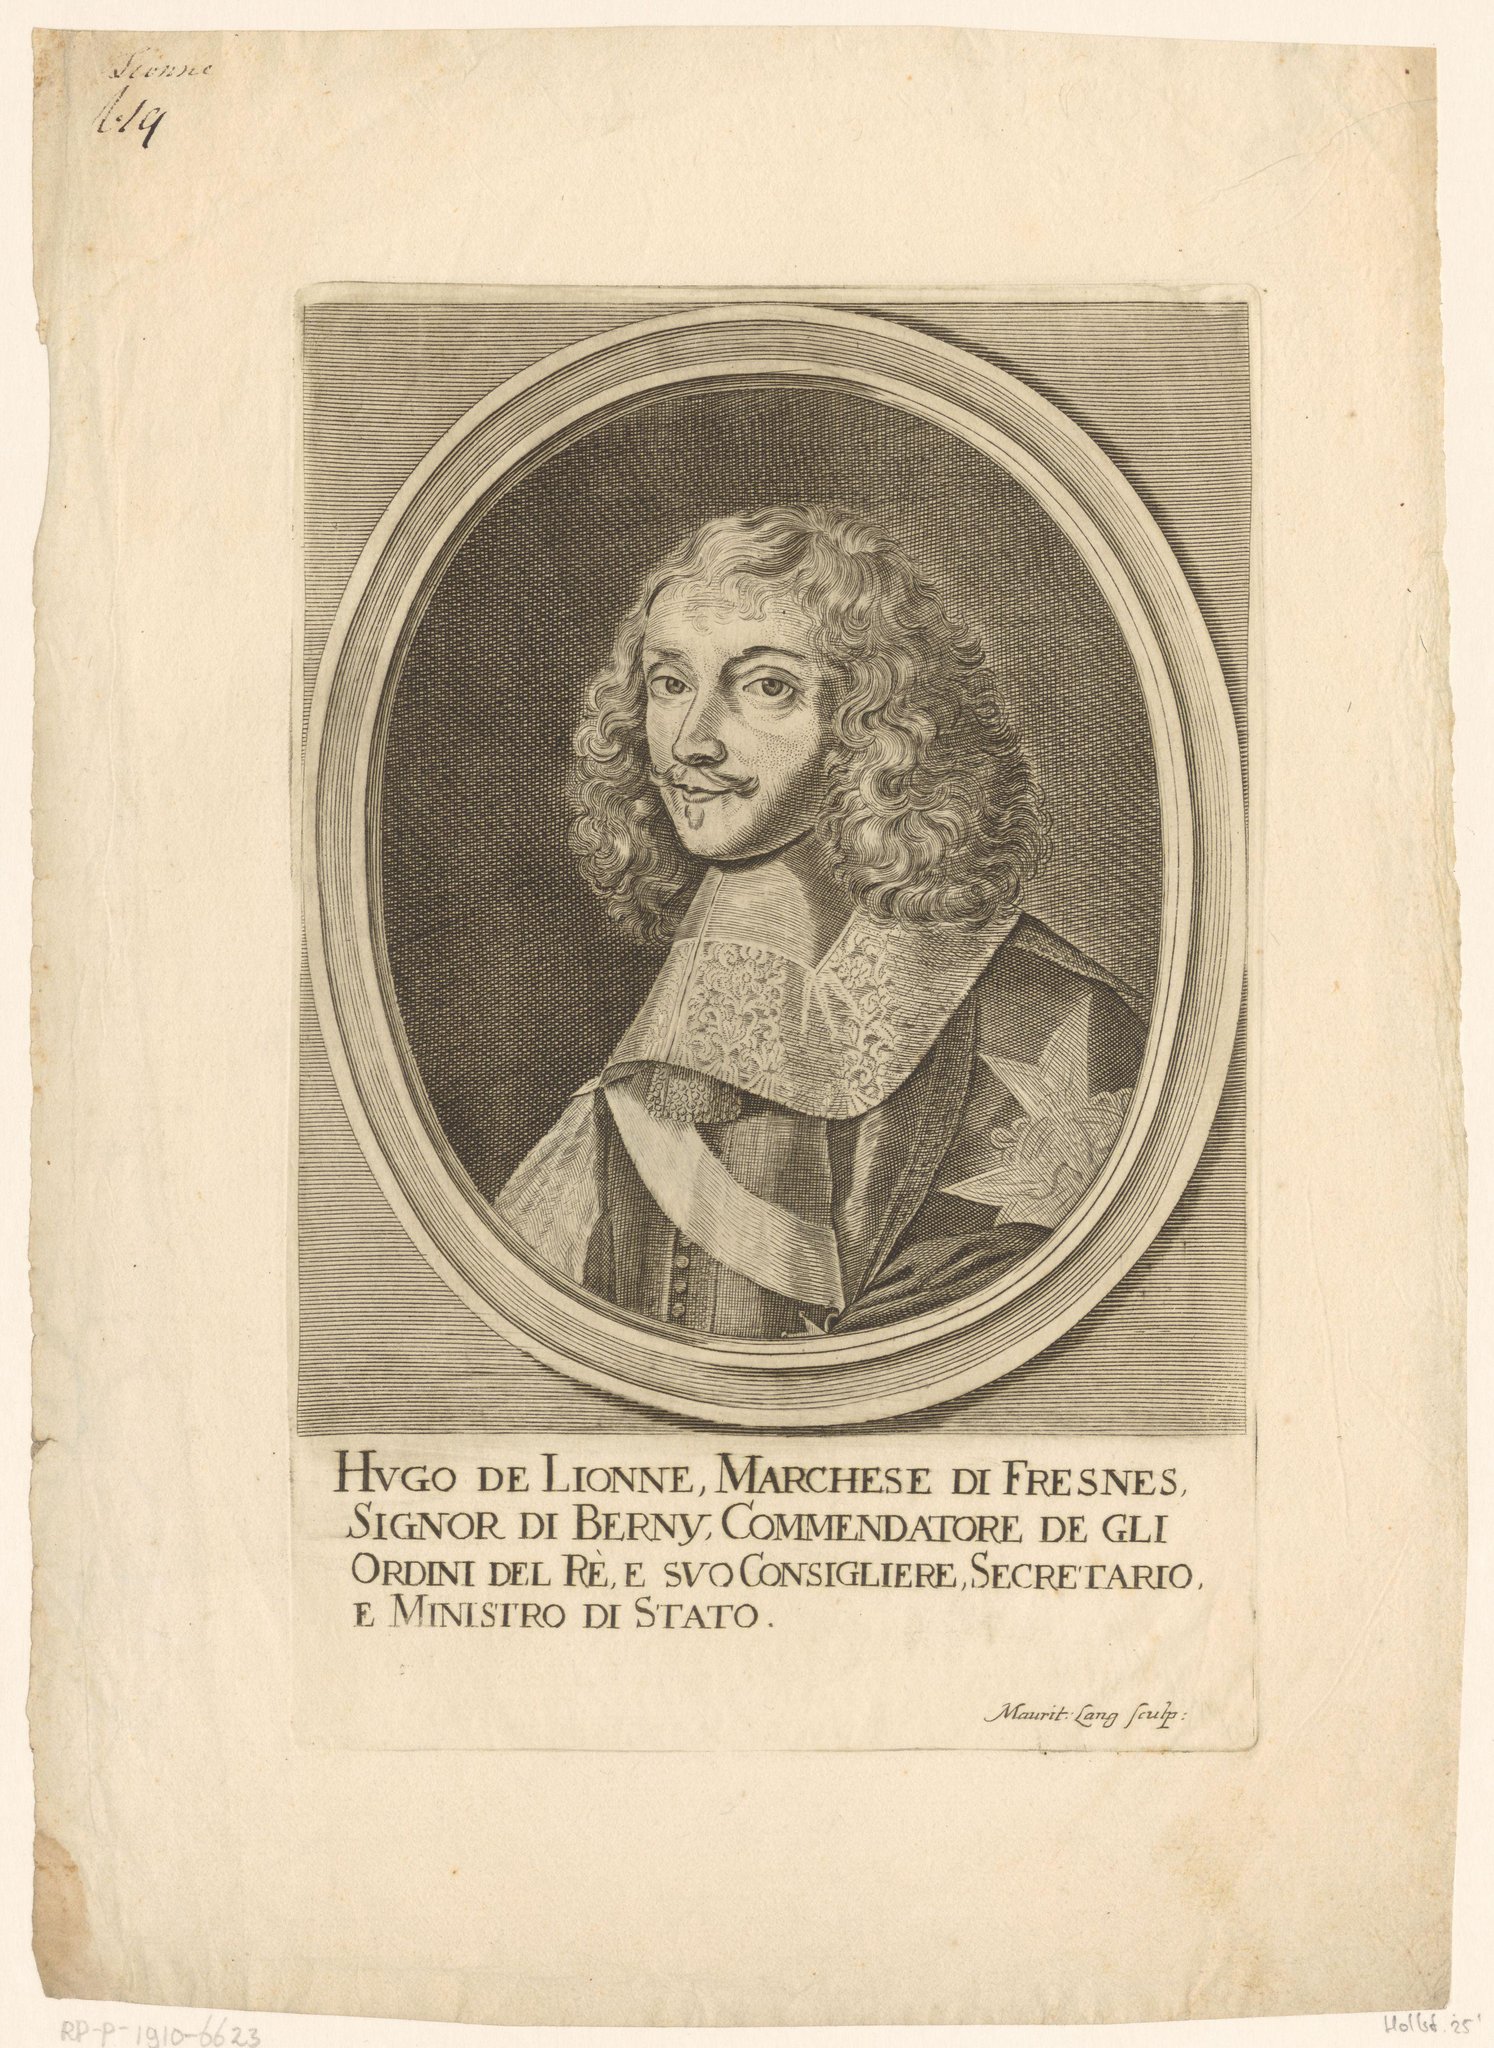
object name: print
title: Portret van Hugues de Lionne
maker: moritz lang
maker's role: draughtsman, print maker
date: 1649-1670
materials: paper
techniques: engraving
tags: paris, historical persons, lawyer, attorney at law, diplomacy, diplomat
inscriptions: collector's mark: Lugt 2228